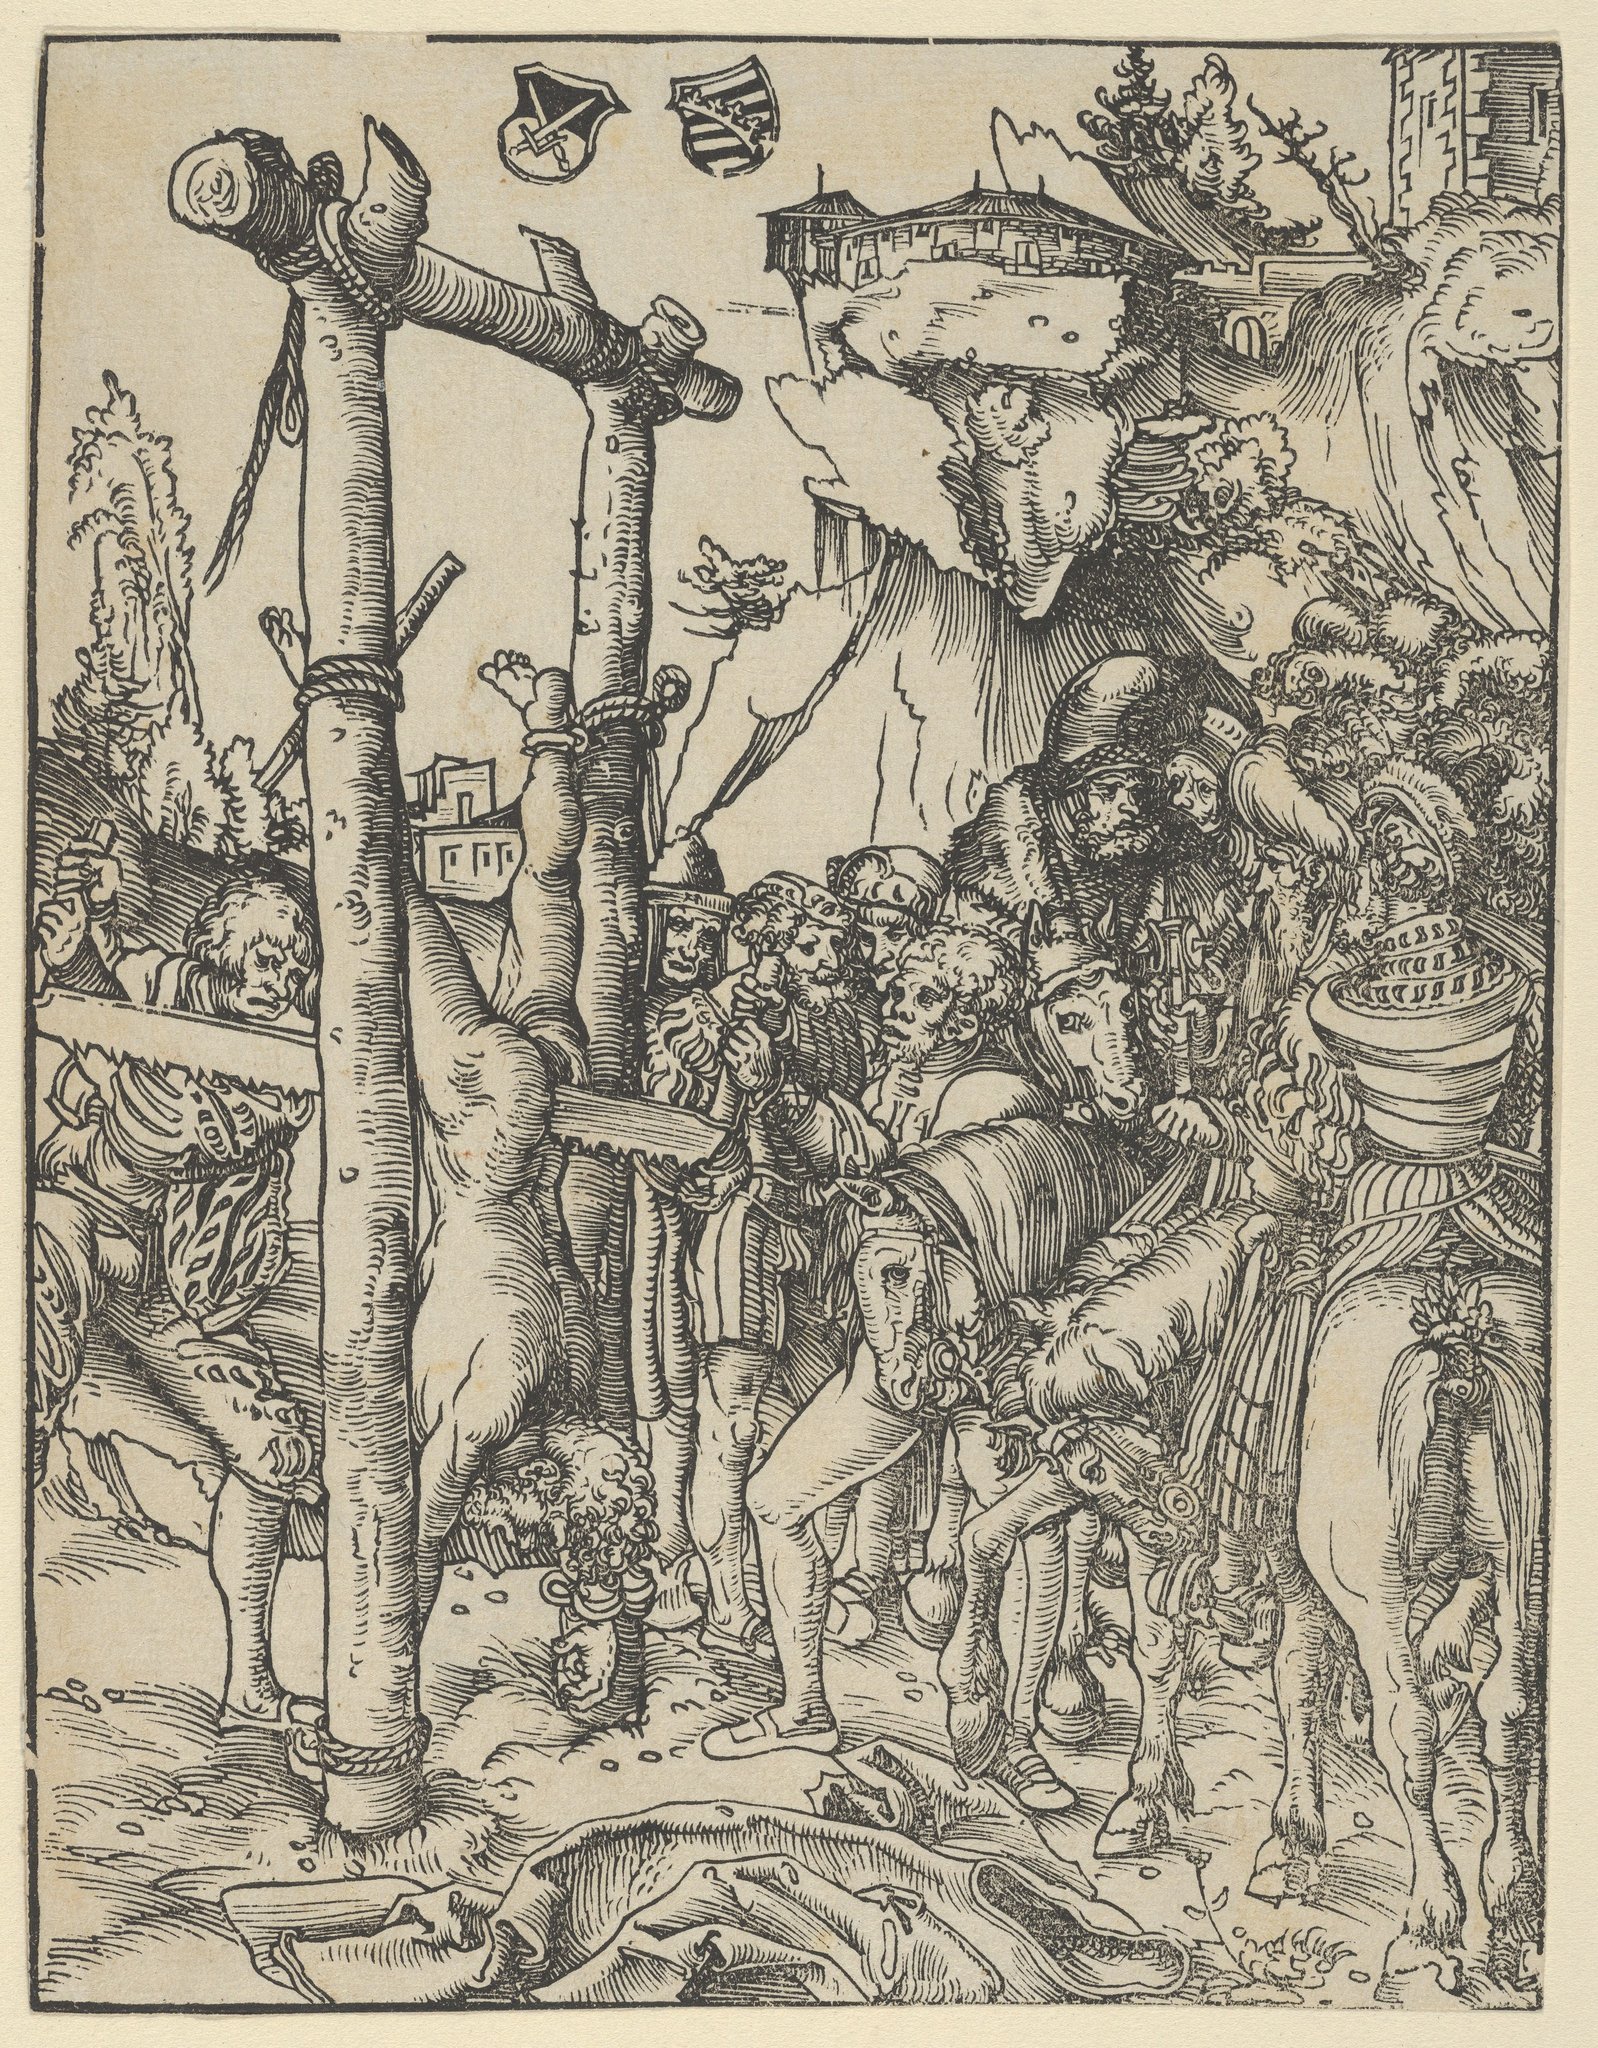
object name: print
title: Simon, from The Martyrdom of the Twelve Apostles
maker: lucas cranach the elder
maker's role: artist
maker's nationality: german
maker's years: 1472-1553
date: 1472-1553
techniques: woodcut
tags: men,male nudes,horses,punishment